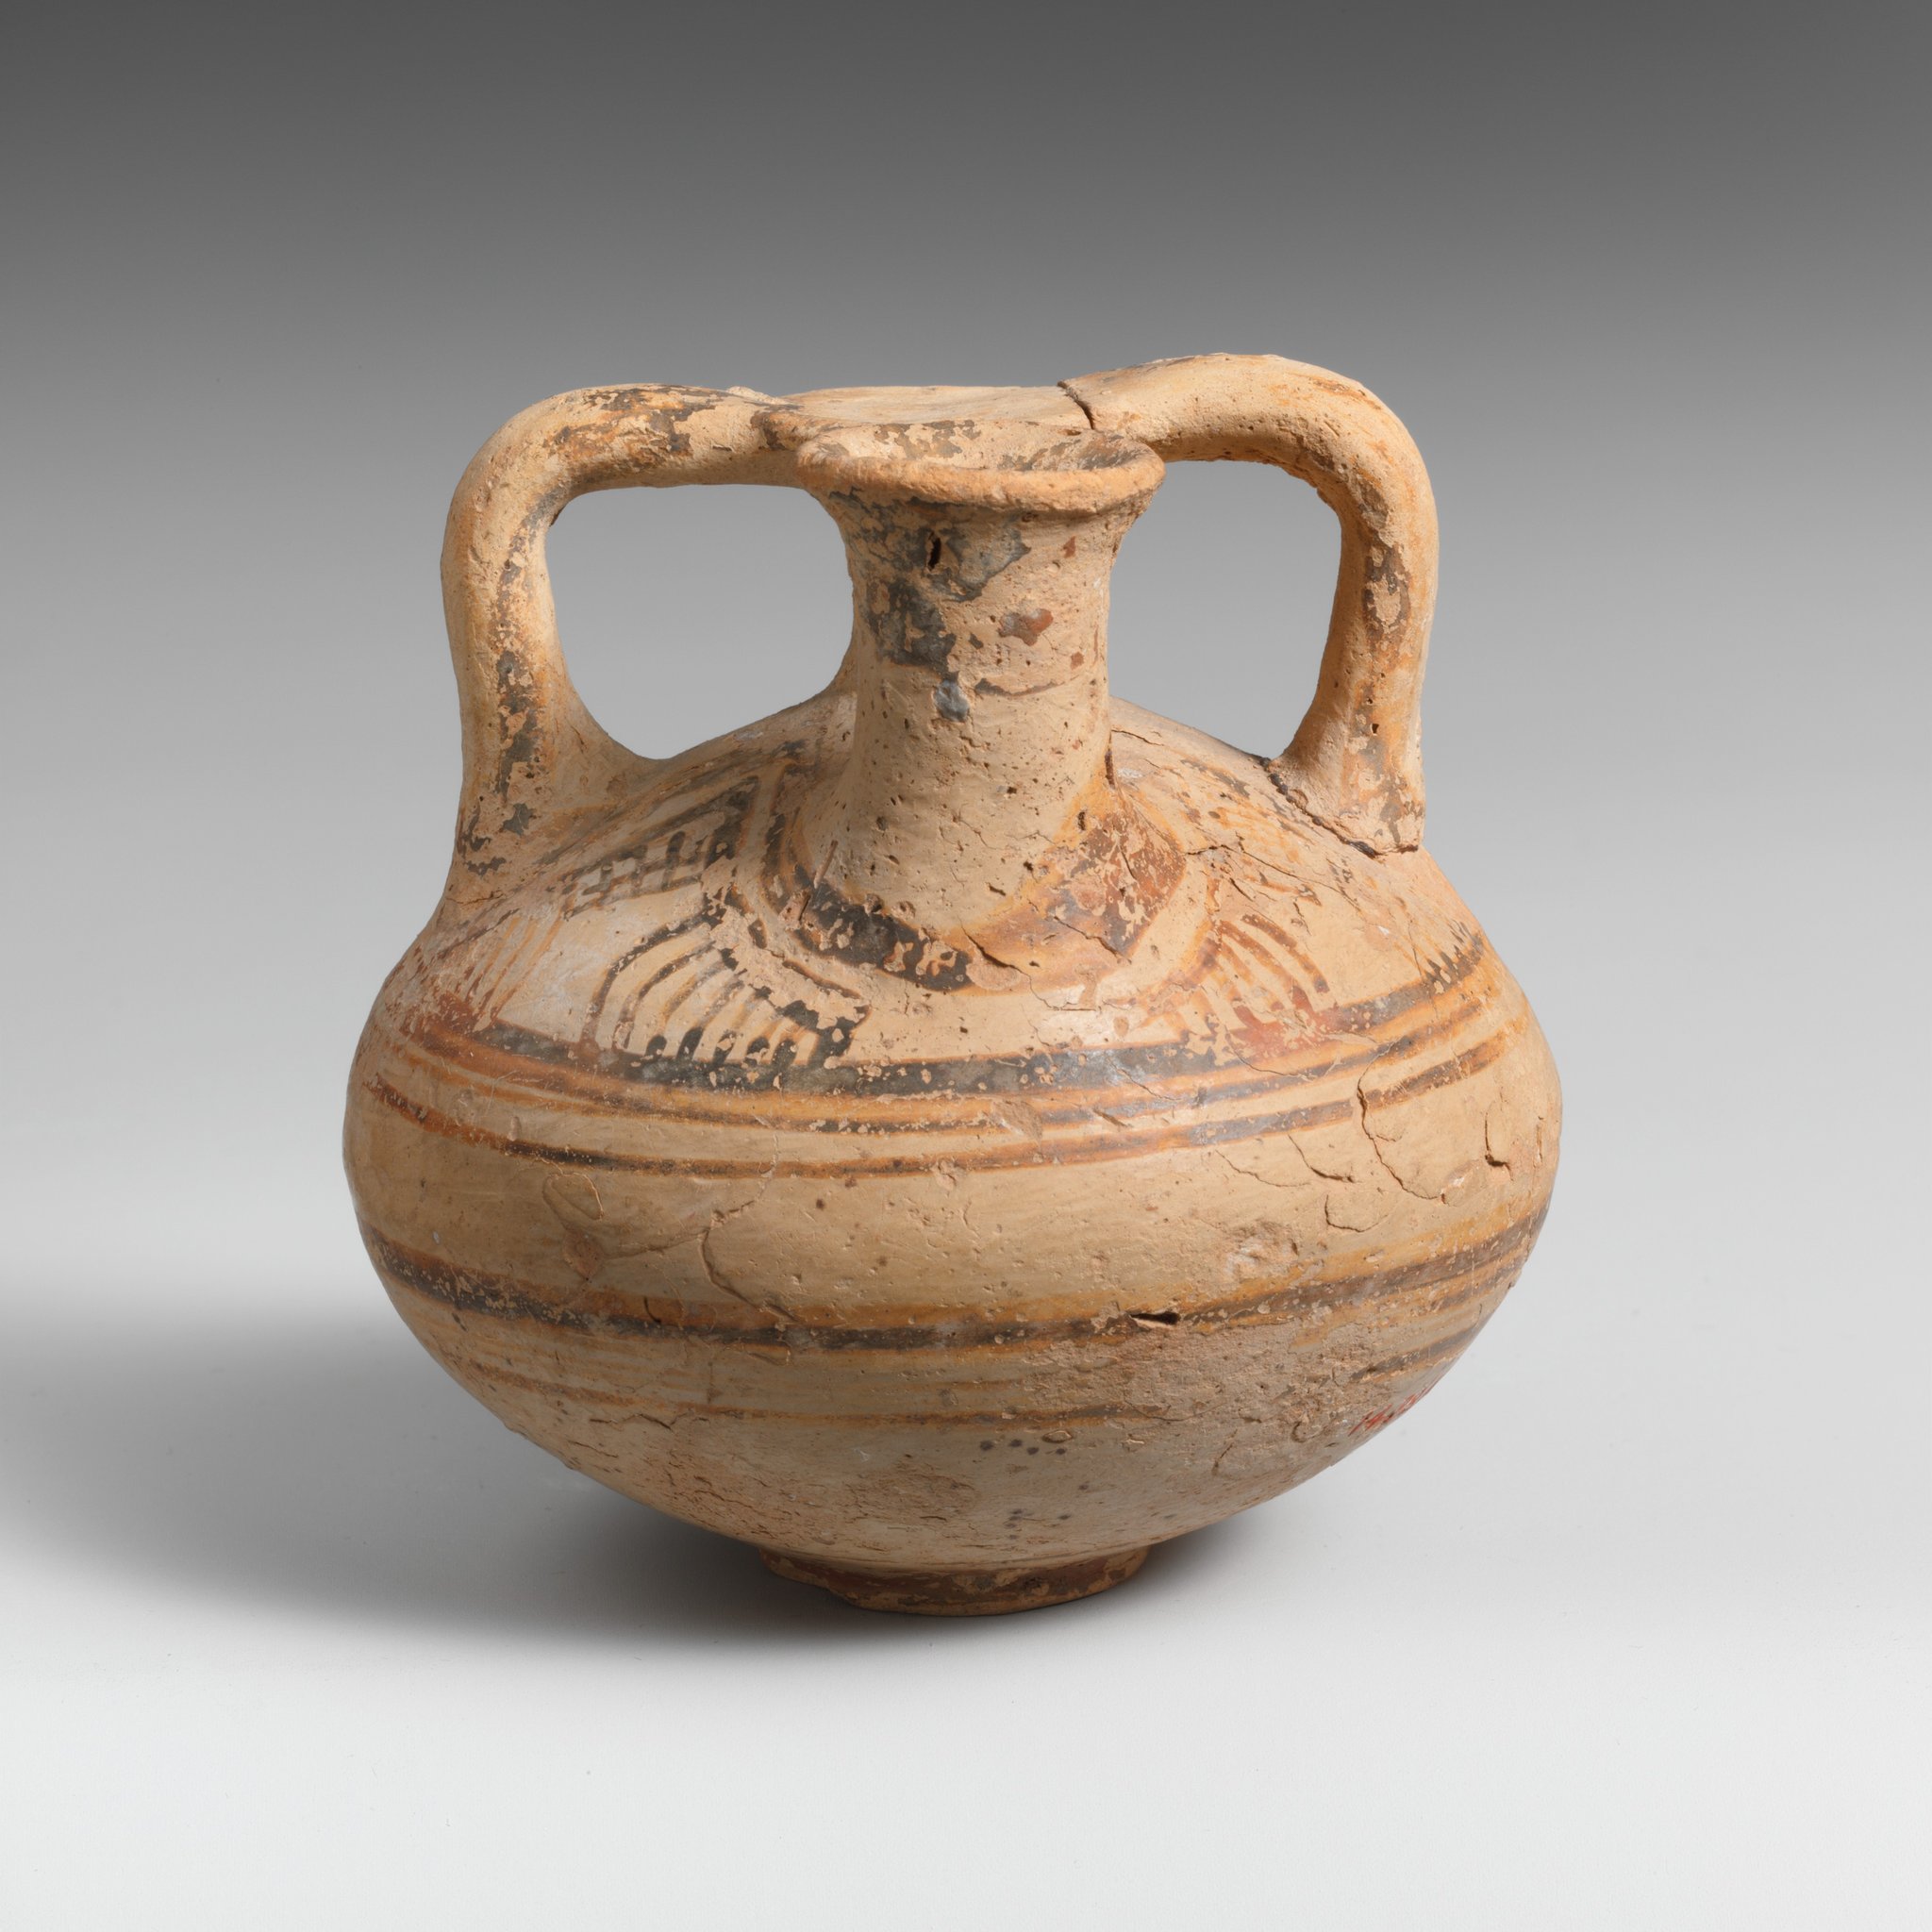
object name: false necked jar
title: Terracotta stirrup jar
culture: minoan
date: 1300-1200 BCE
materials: terracotta